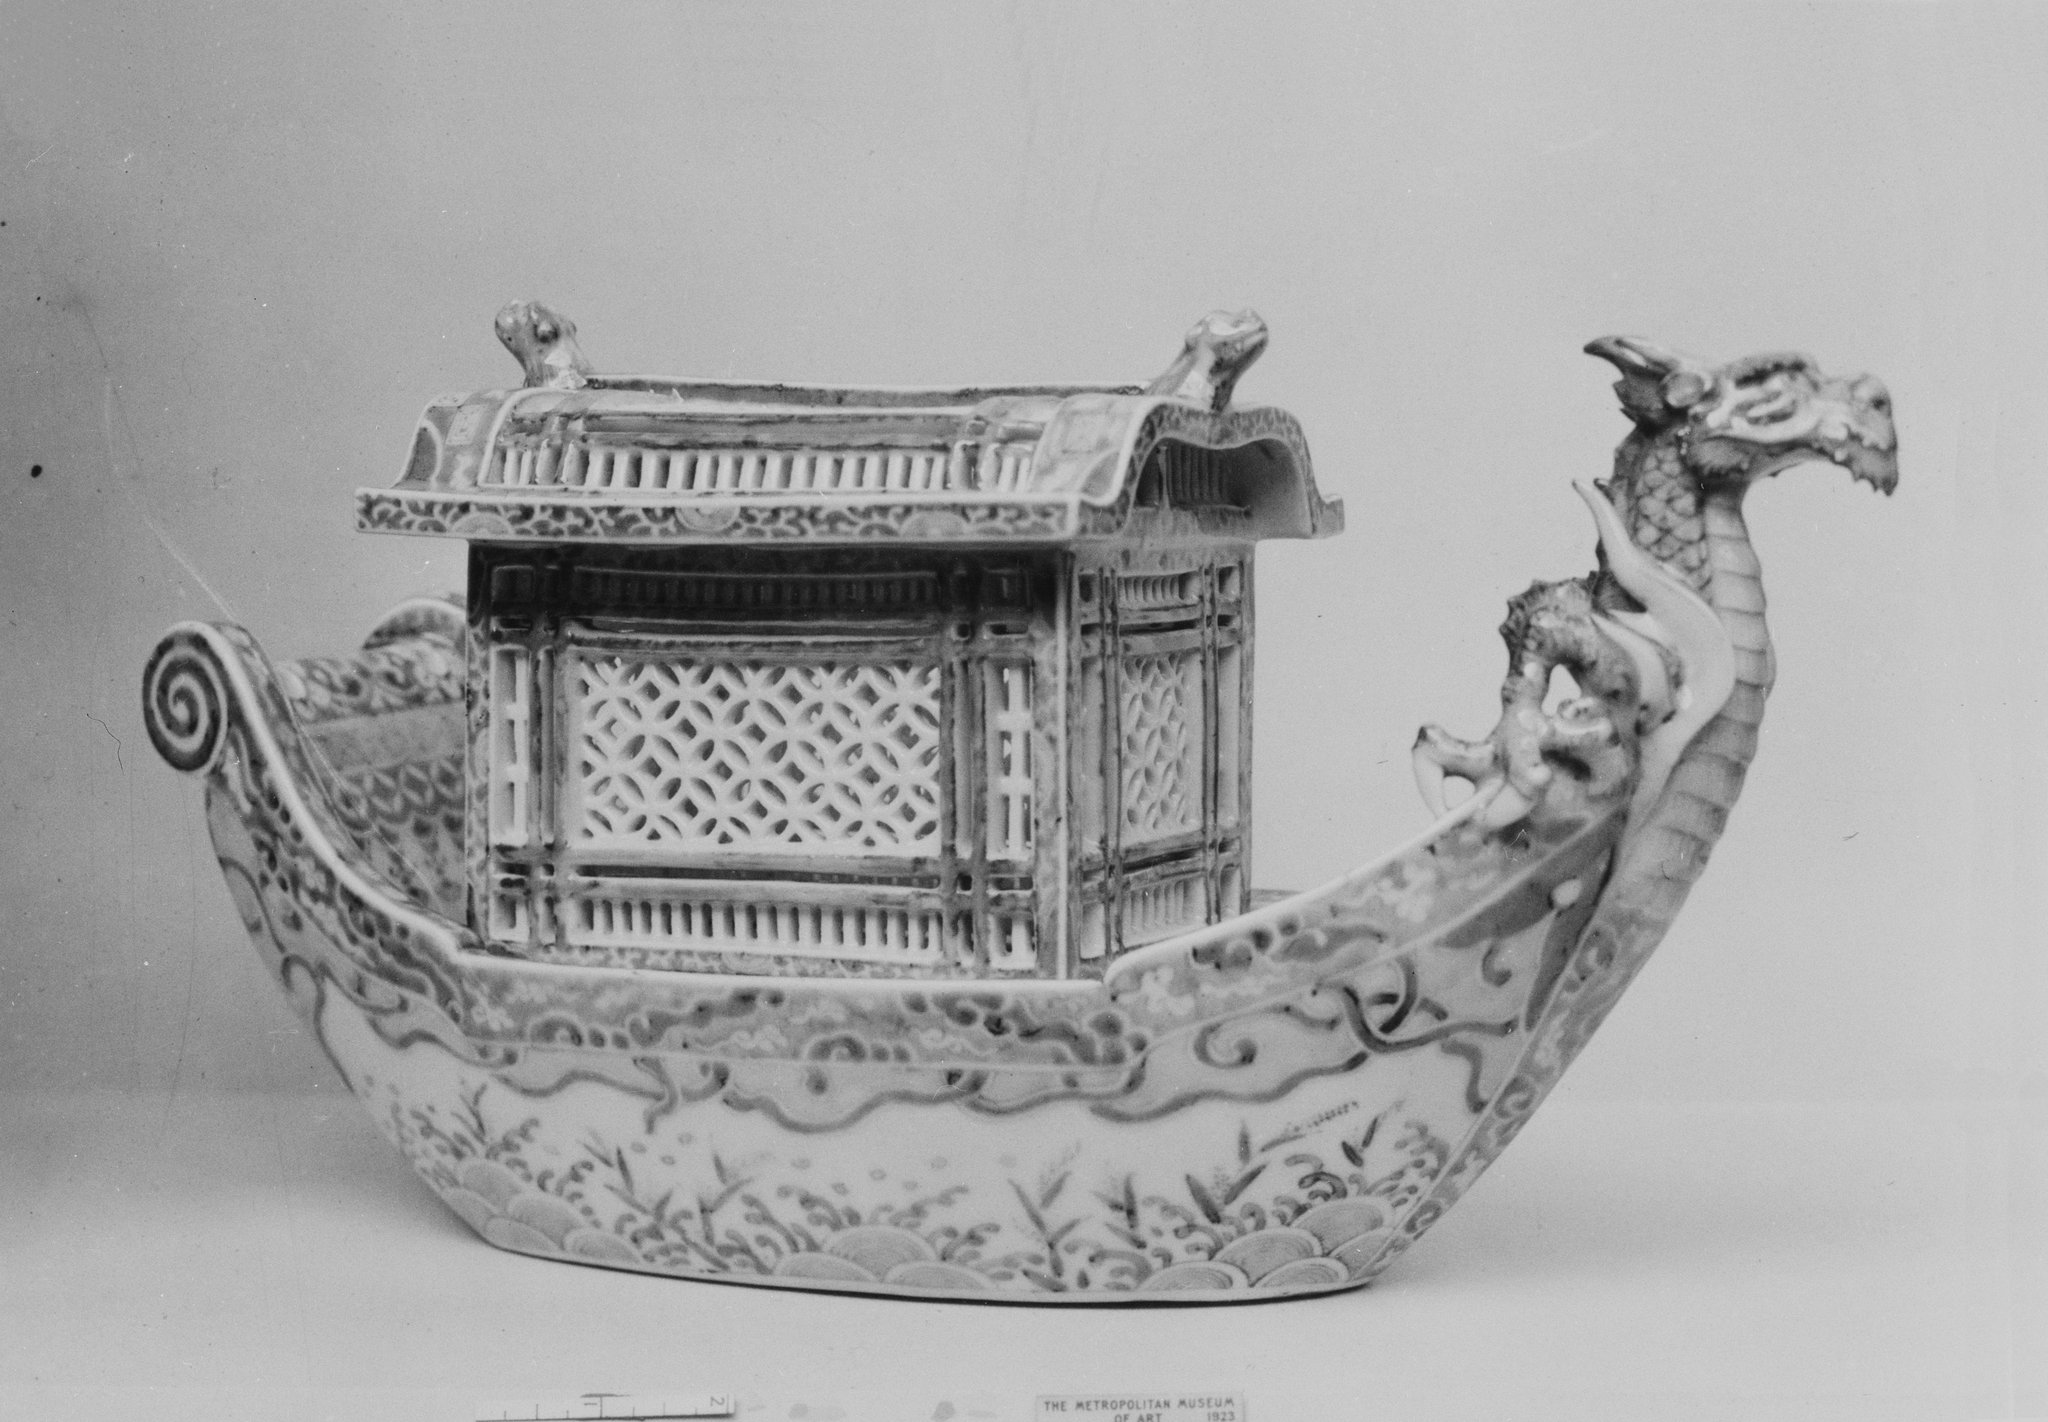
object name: censer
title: Censer in form of a Pleasure Boat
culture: japanese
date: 1830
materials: glaze, porcelain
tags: dragons,censers,boats